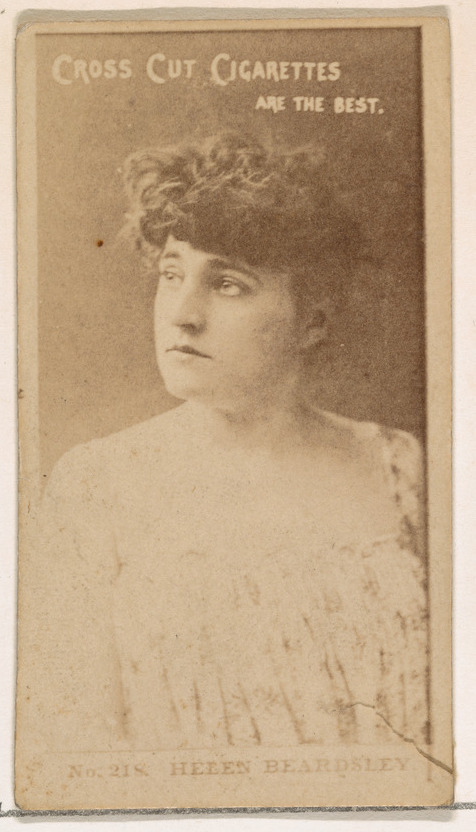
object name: print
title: Card Number 218, Helen Beardsley, from the Actors and Actresses series (N145-2) issued by Duke Sons & Co. to promote Cross Cut Cigarettes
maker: w. duke, sons & co.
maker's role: publisher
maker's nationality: american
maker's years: 1870-1920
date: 1880-1889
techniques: albumen silver print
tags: portraits,women,actresses